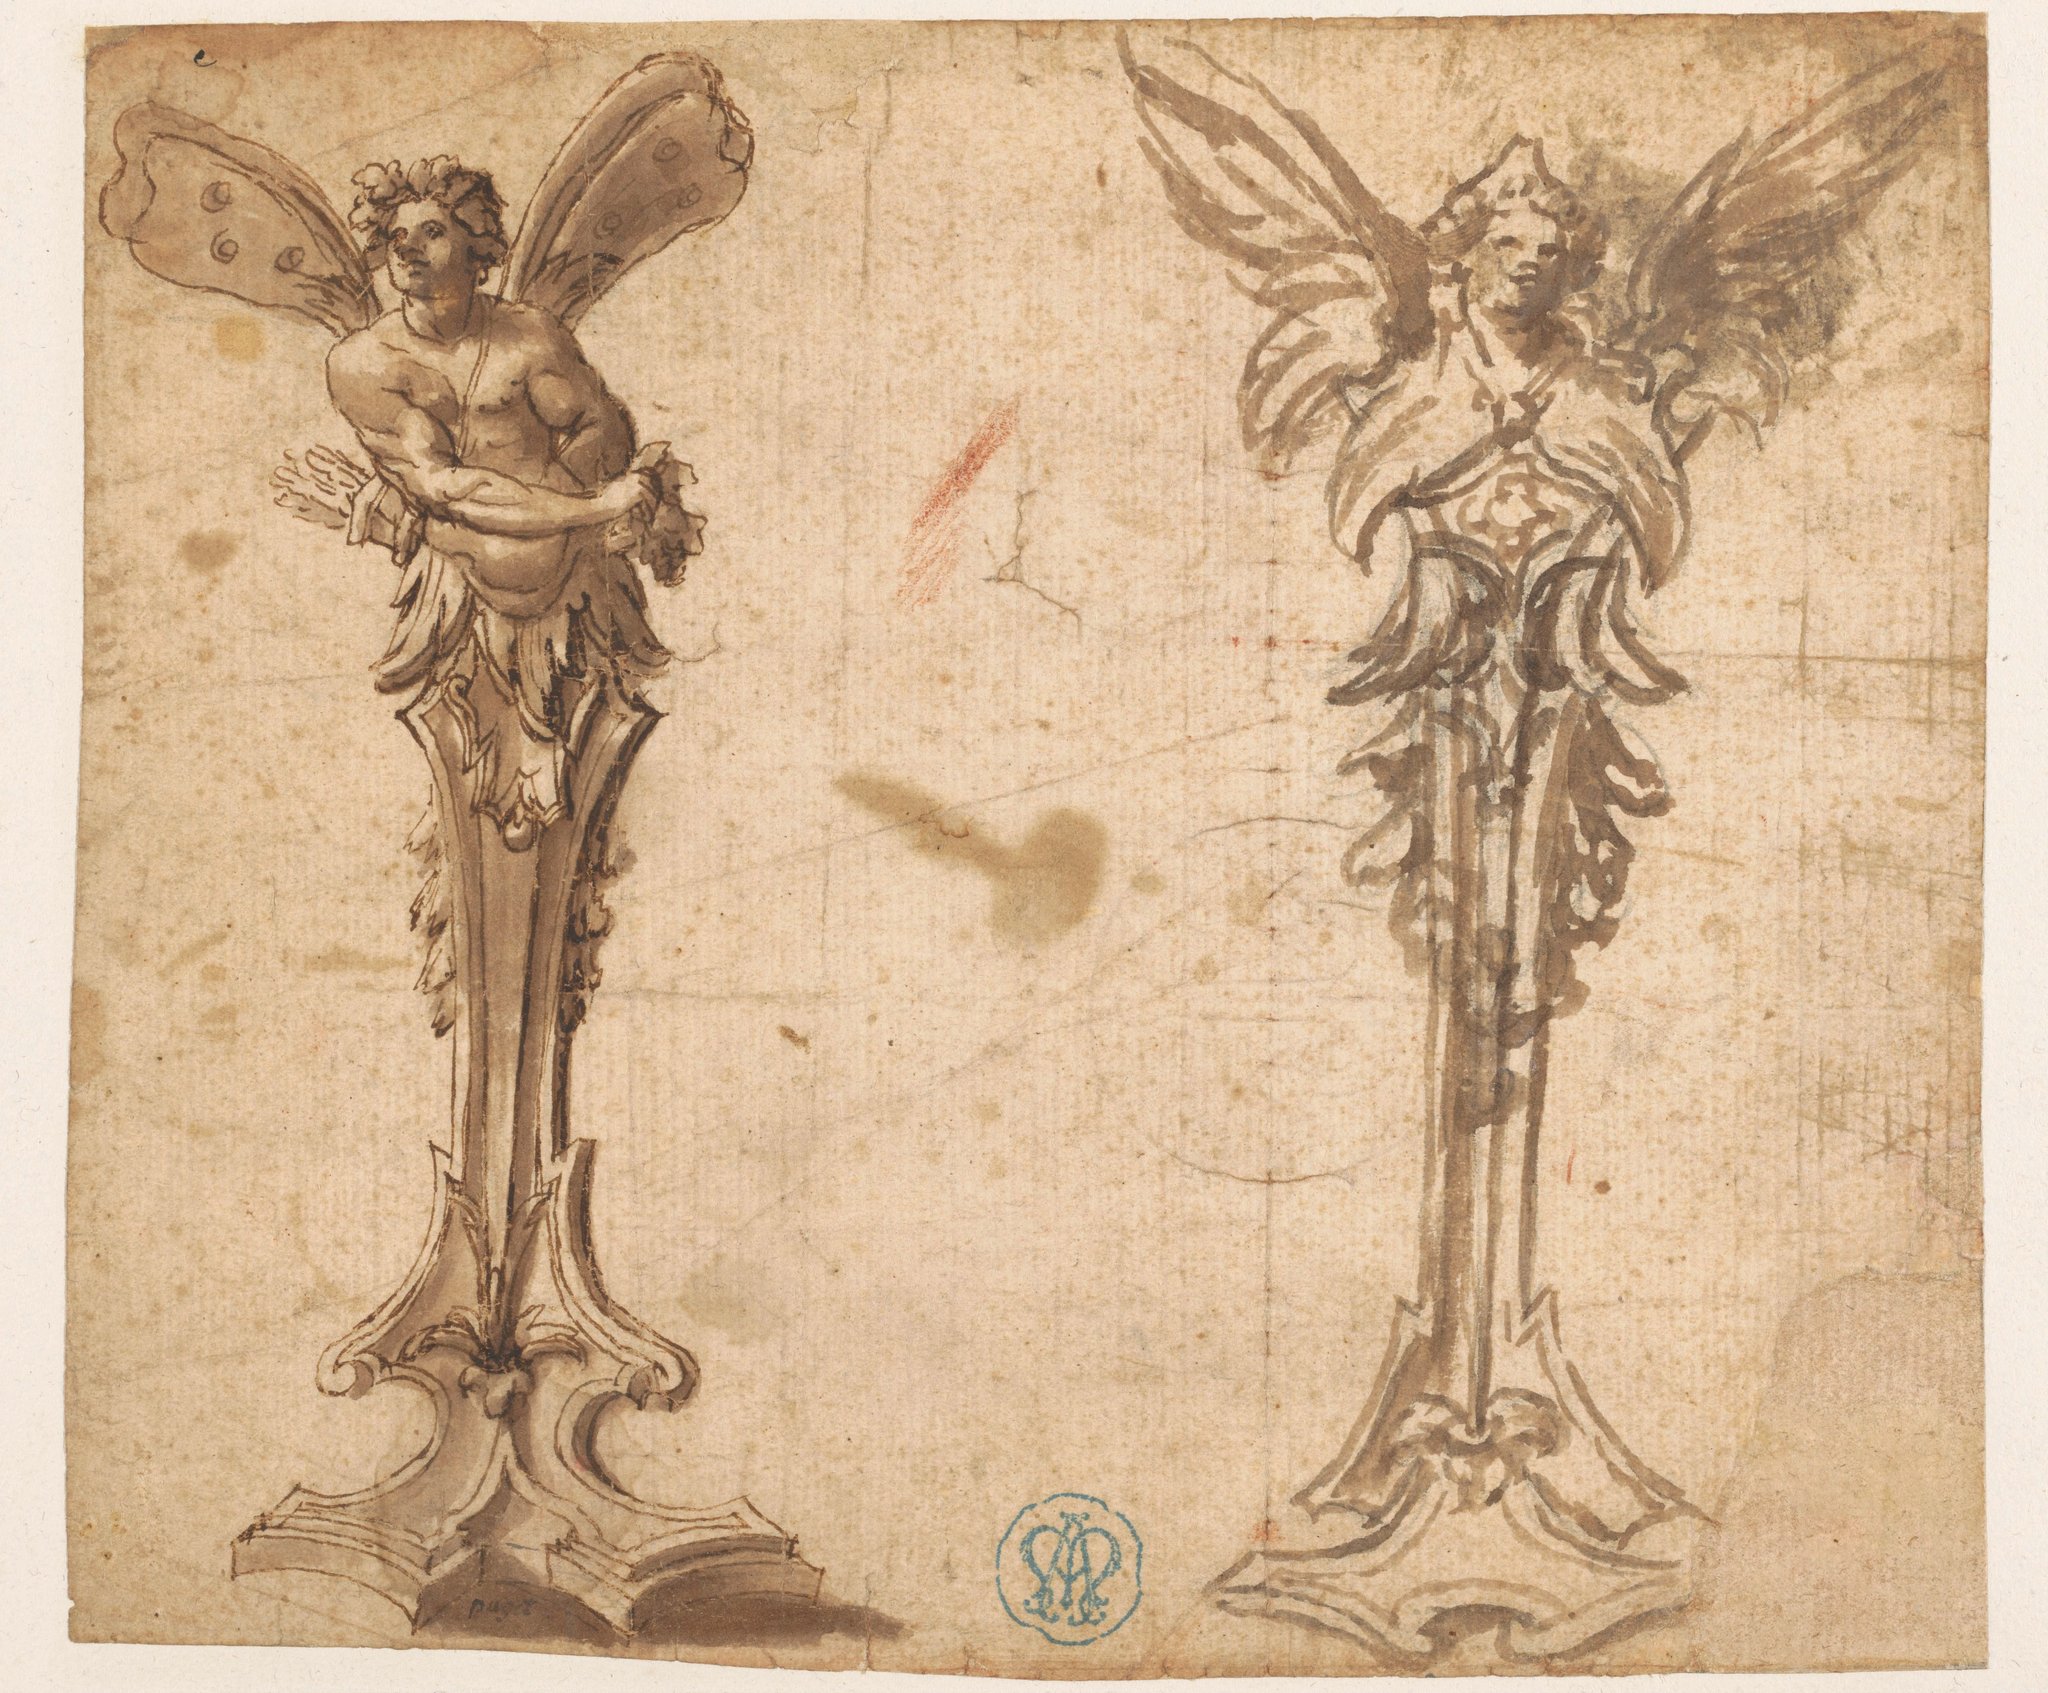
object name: design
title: Twee ontwerpen voor gevleugelde hermen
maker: pierre puget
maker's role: draughtsman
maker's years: 1620-1694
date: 1630-1694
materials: ink, paper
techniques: brush, pen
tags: chandelier, candelabrum, pedestal of a piece of sculpture (perhaps in the form of a herm), candlestick